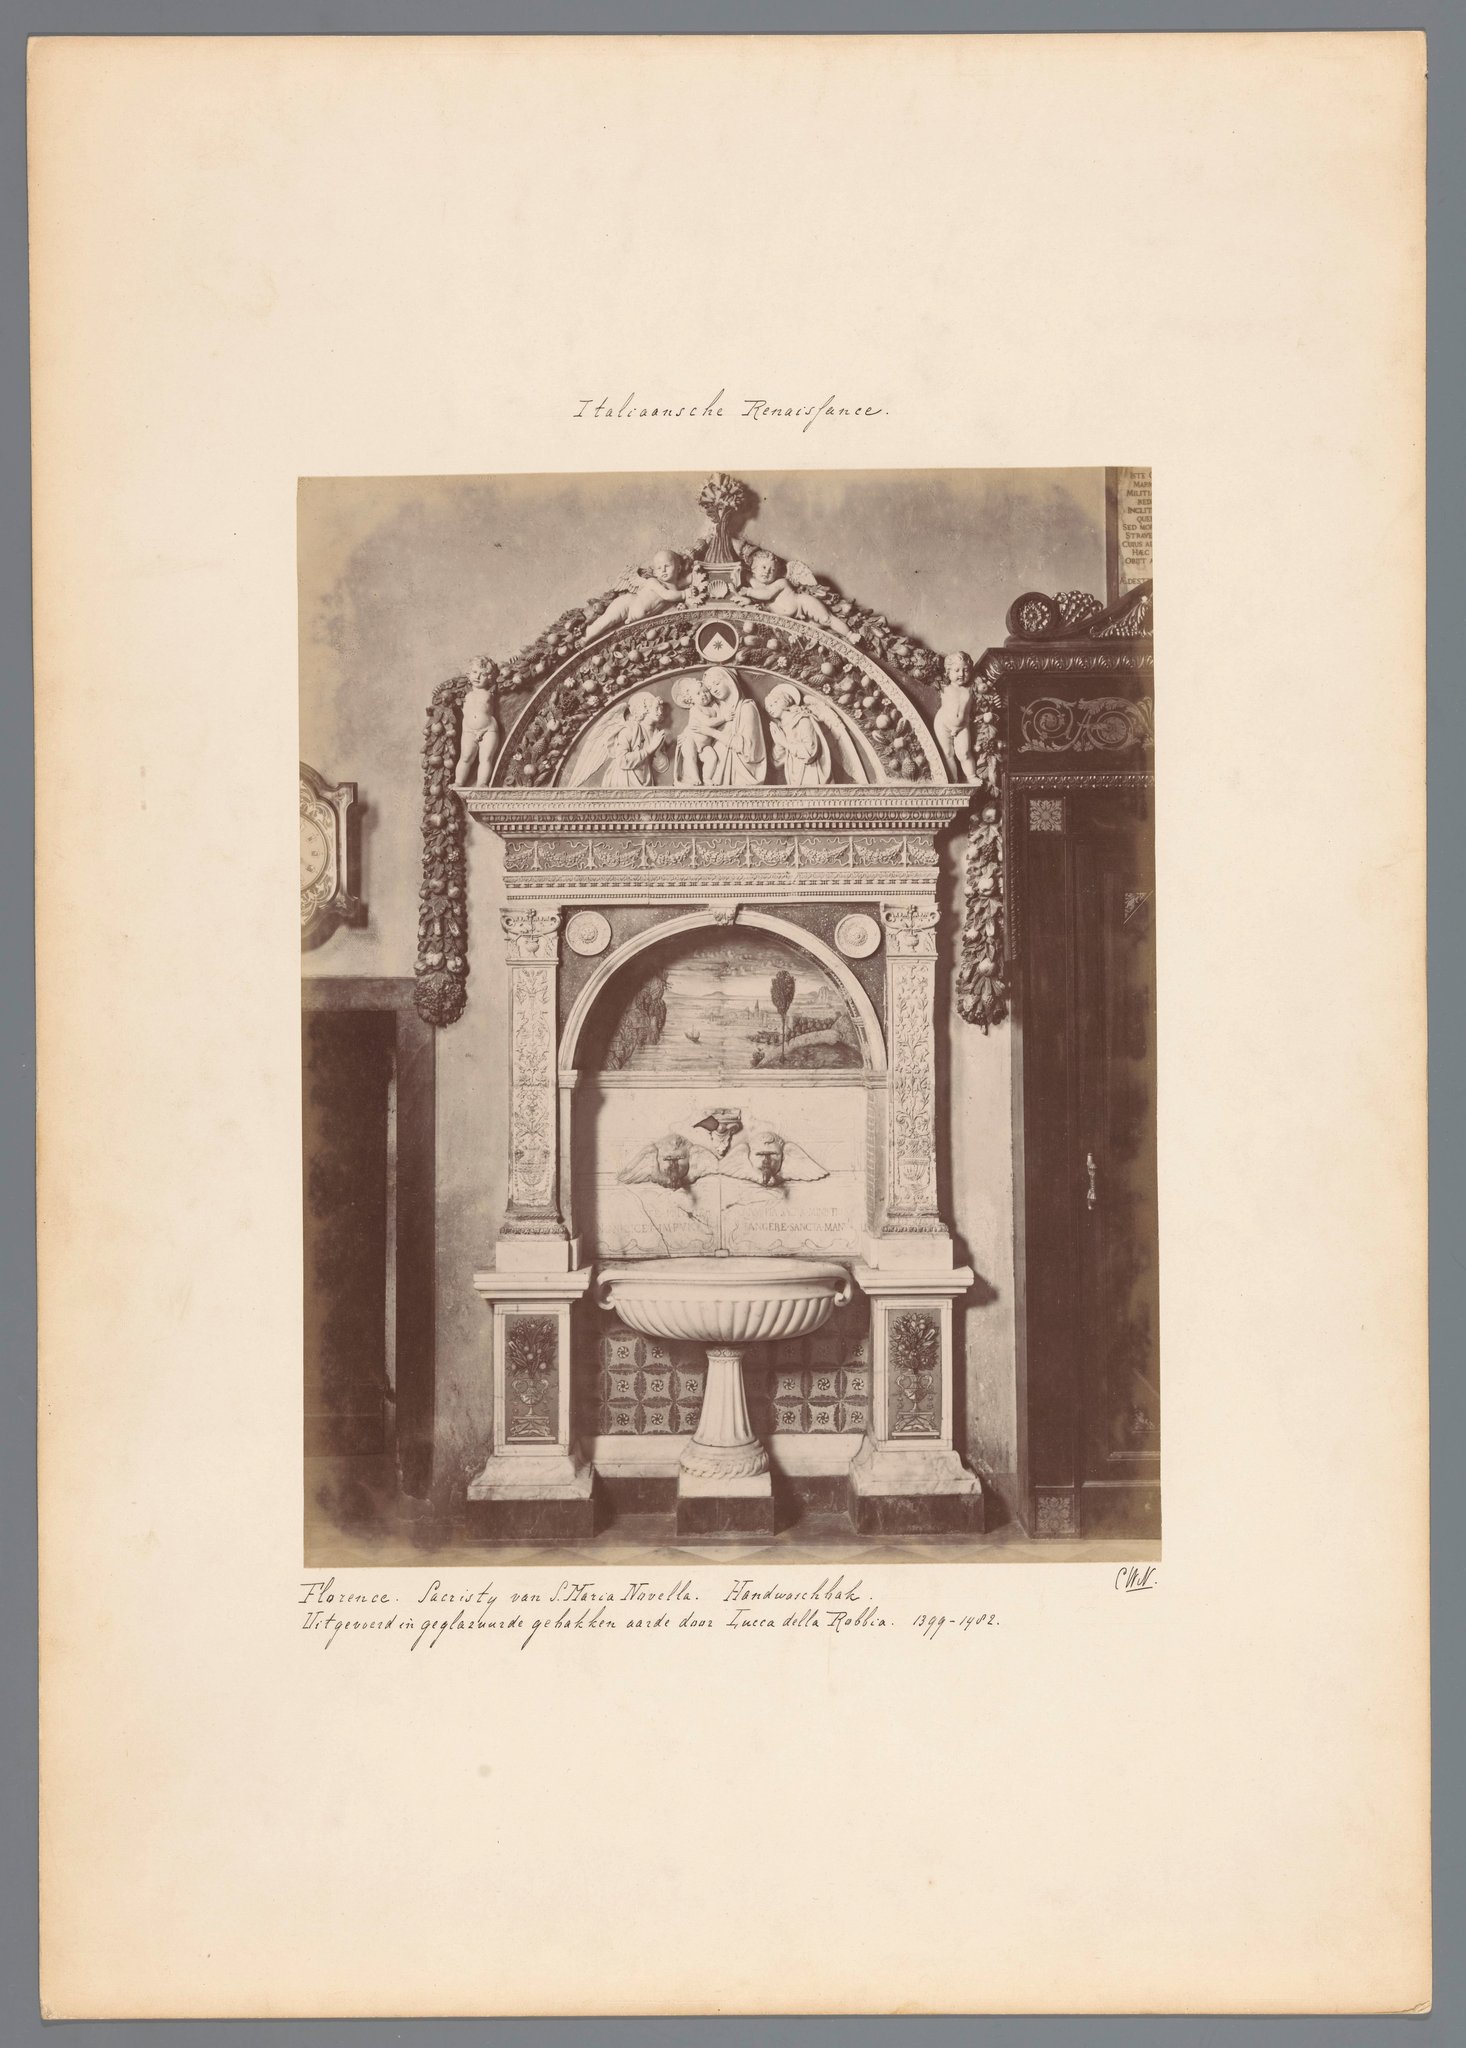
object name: photograph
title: Florence. Sacristy van S. Maria Novella. Handwasbak.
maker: Anonymous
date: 1875-1900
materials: cardboard, photographic support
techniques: albumen print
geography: santa maria novella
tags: cherubs, i.e. children's heads with wings, jug and basin; wash-basin, parts of church interior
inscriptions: inscription: ‘CWN.’, inscription: ‘Italiaansche Renaissance.’, collector's mark: ‘KUNSTNIJVERHEIDSCHOOL QUELLINUS AMSTERDAM FRANS HALSSTRAAT 14.’, collector's mark: ‘INSTITUUT VOOR KUNST-NIJVERHEIDSONDERWIJS GABRIËL METSUSTRAAT No. 16 AMSTERDAM’